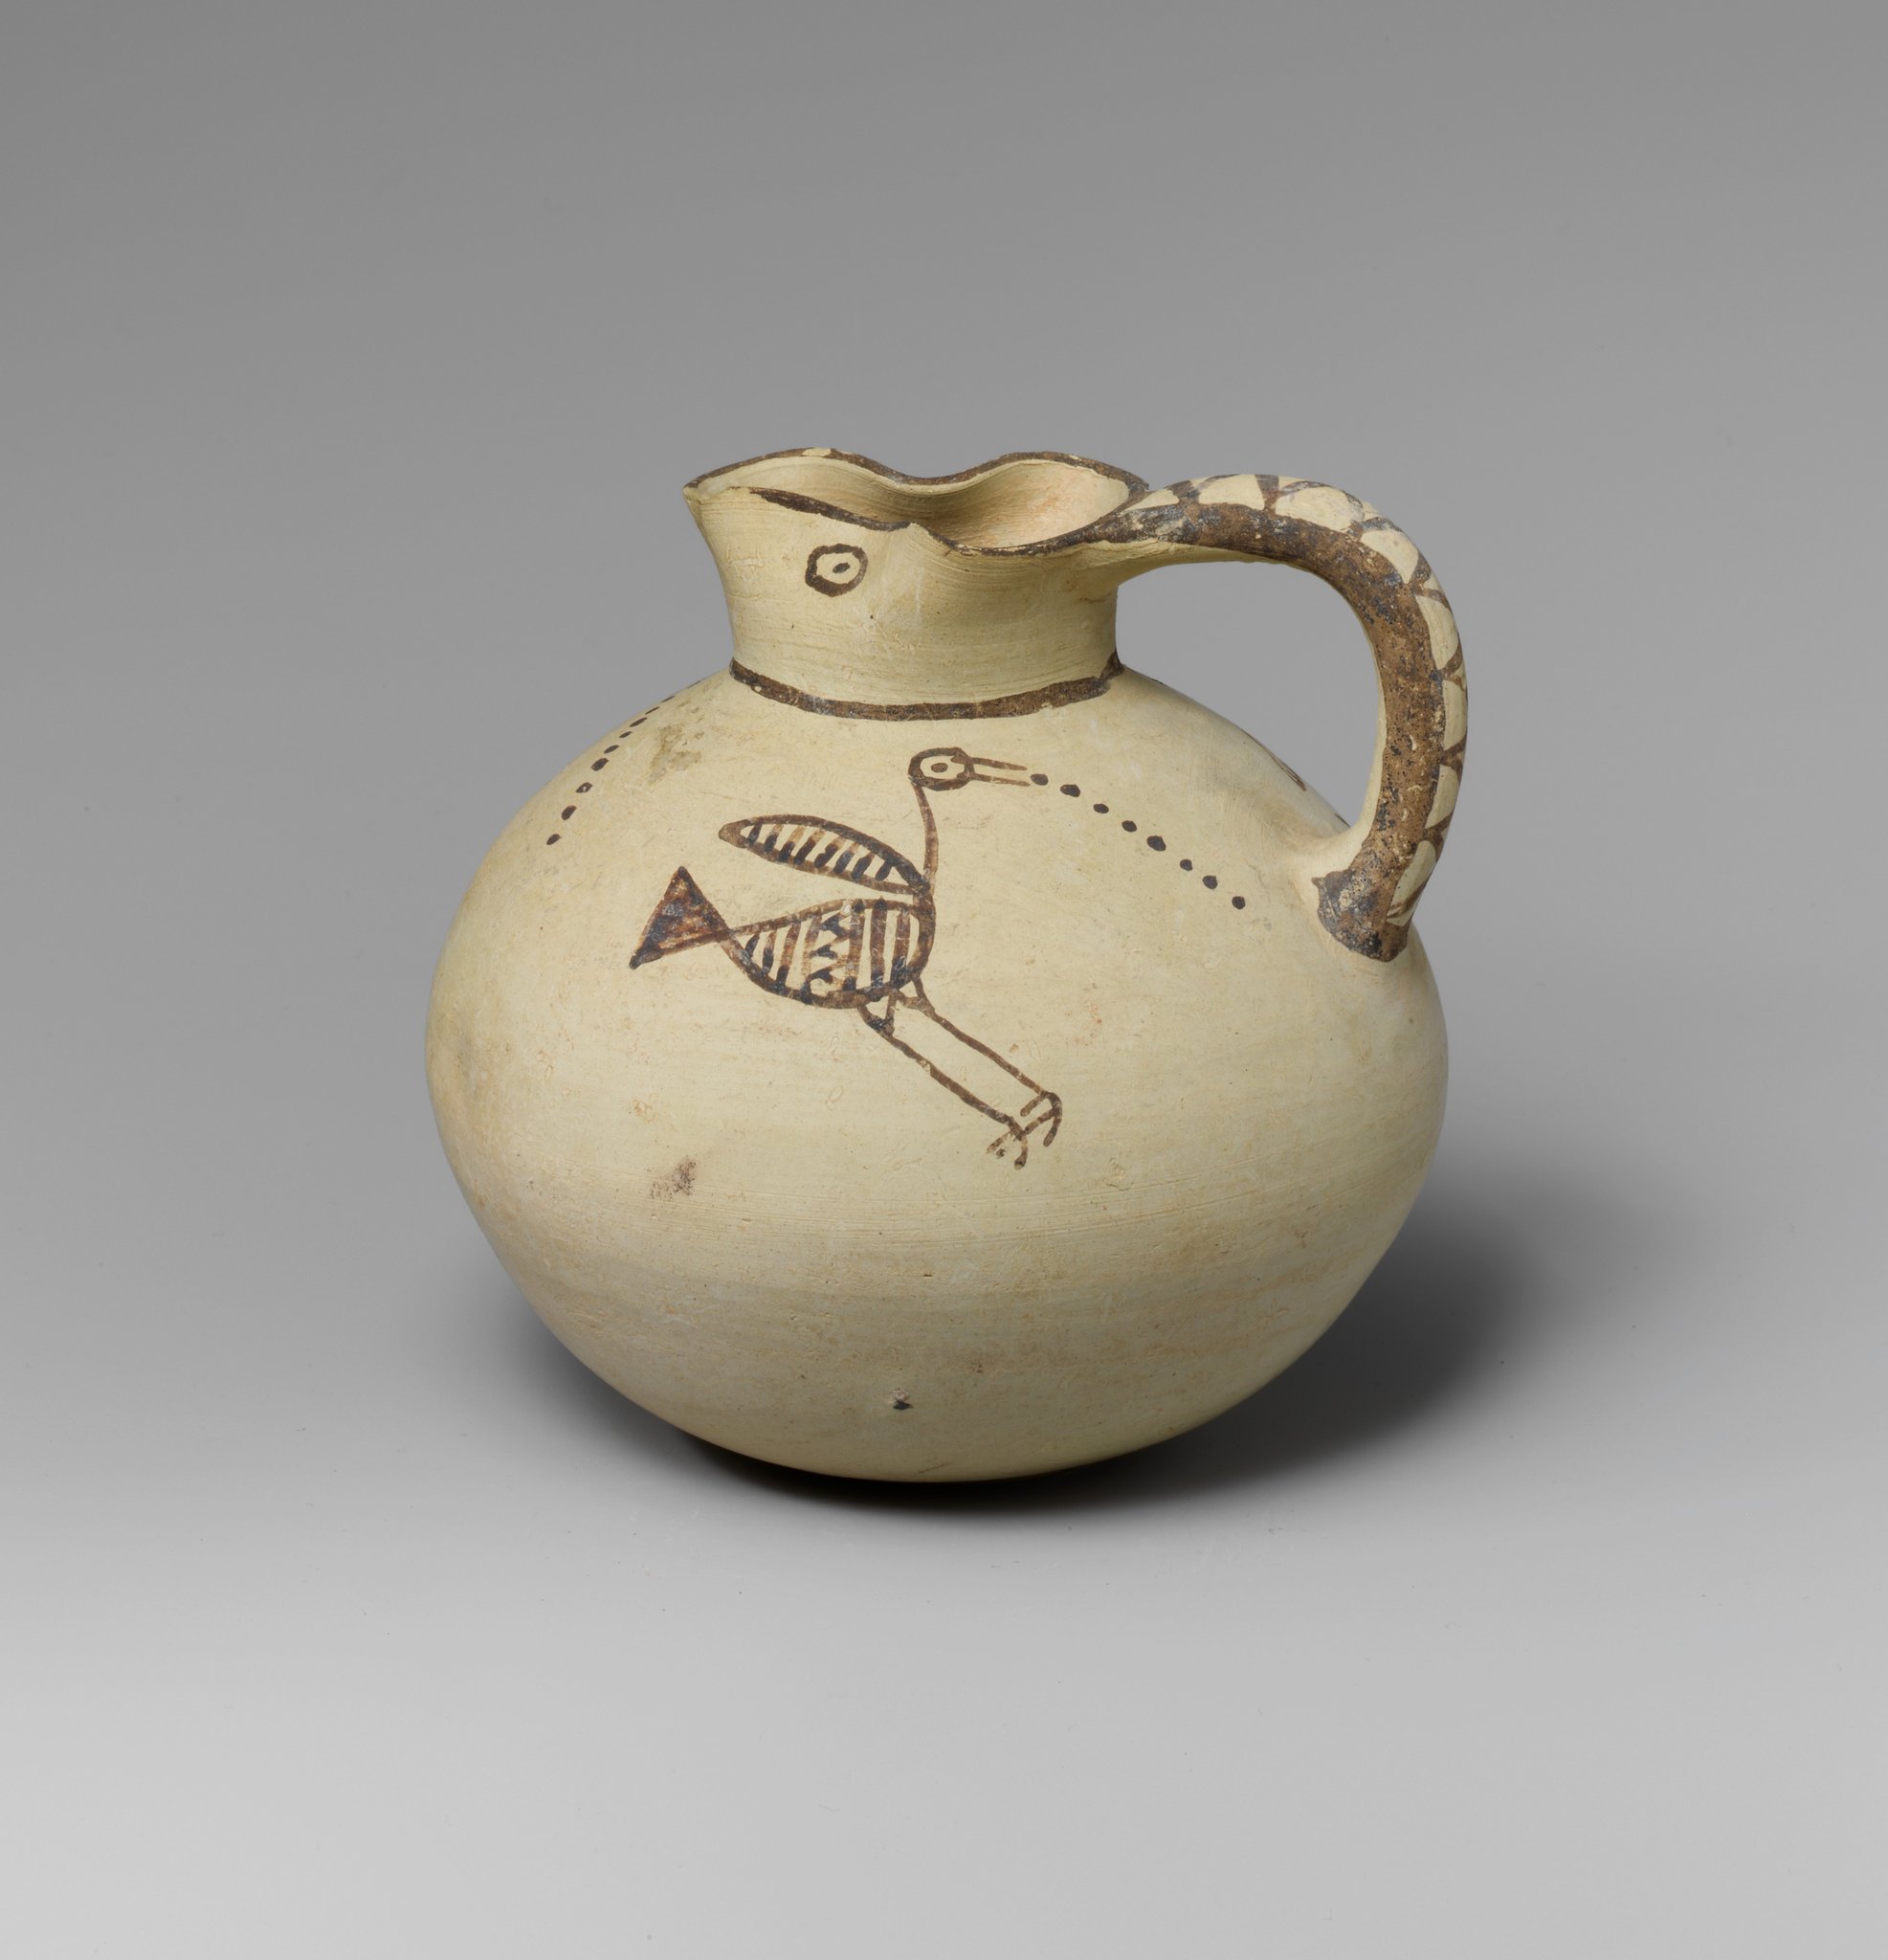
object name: jug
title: Terracotta jug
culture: cypriot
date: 750-600 BCE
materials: terracotta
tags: birds